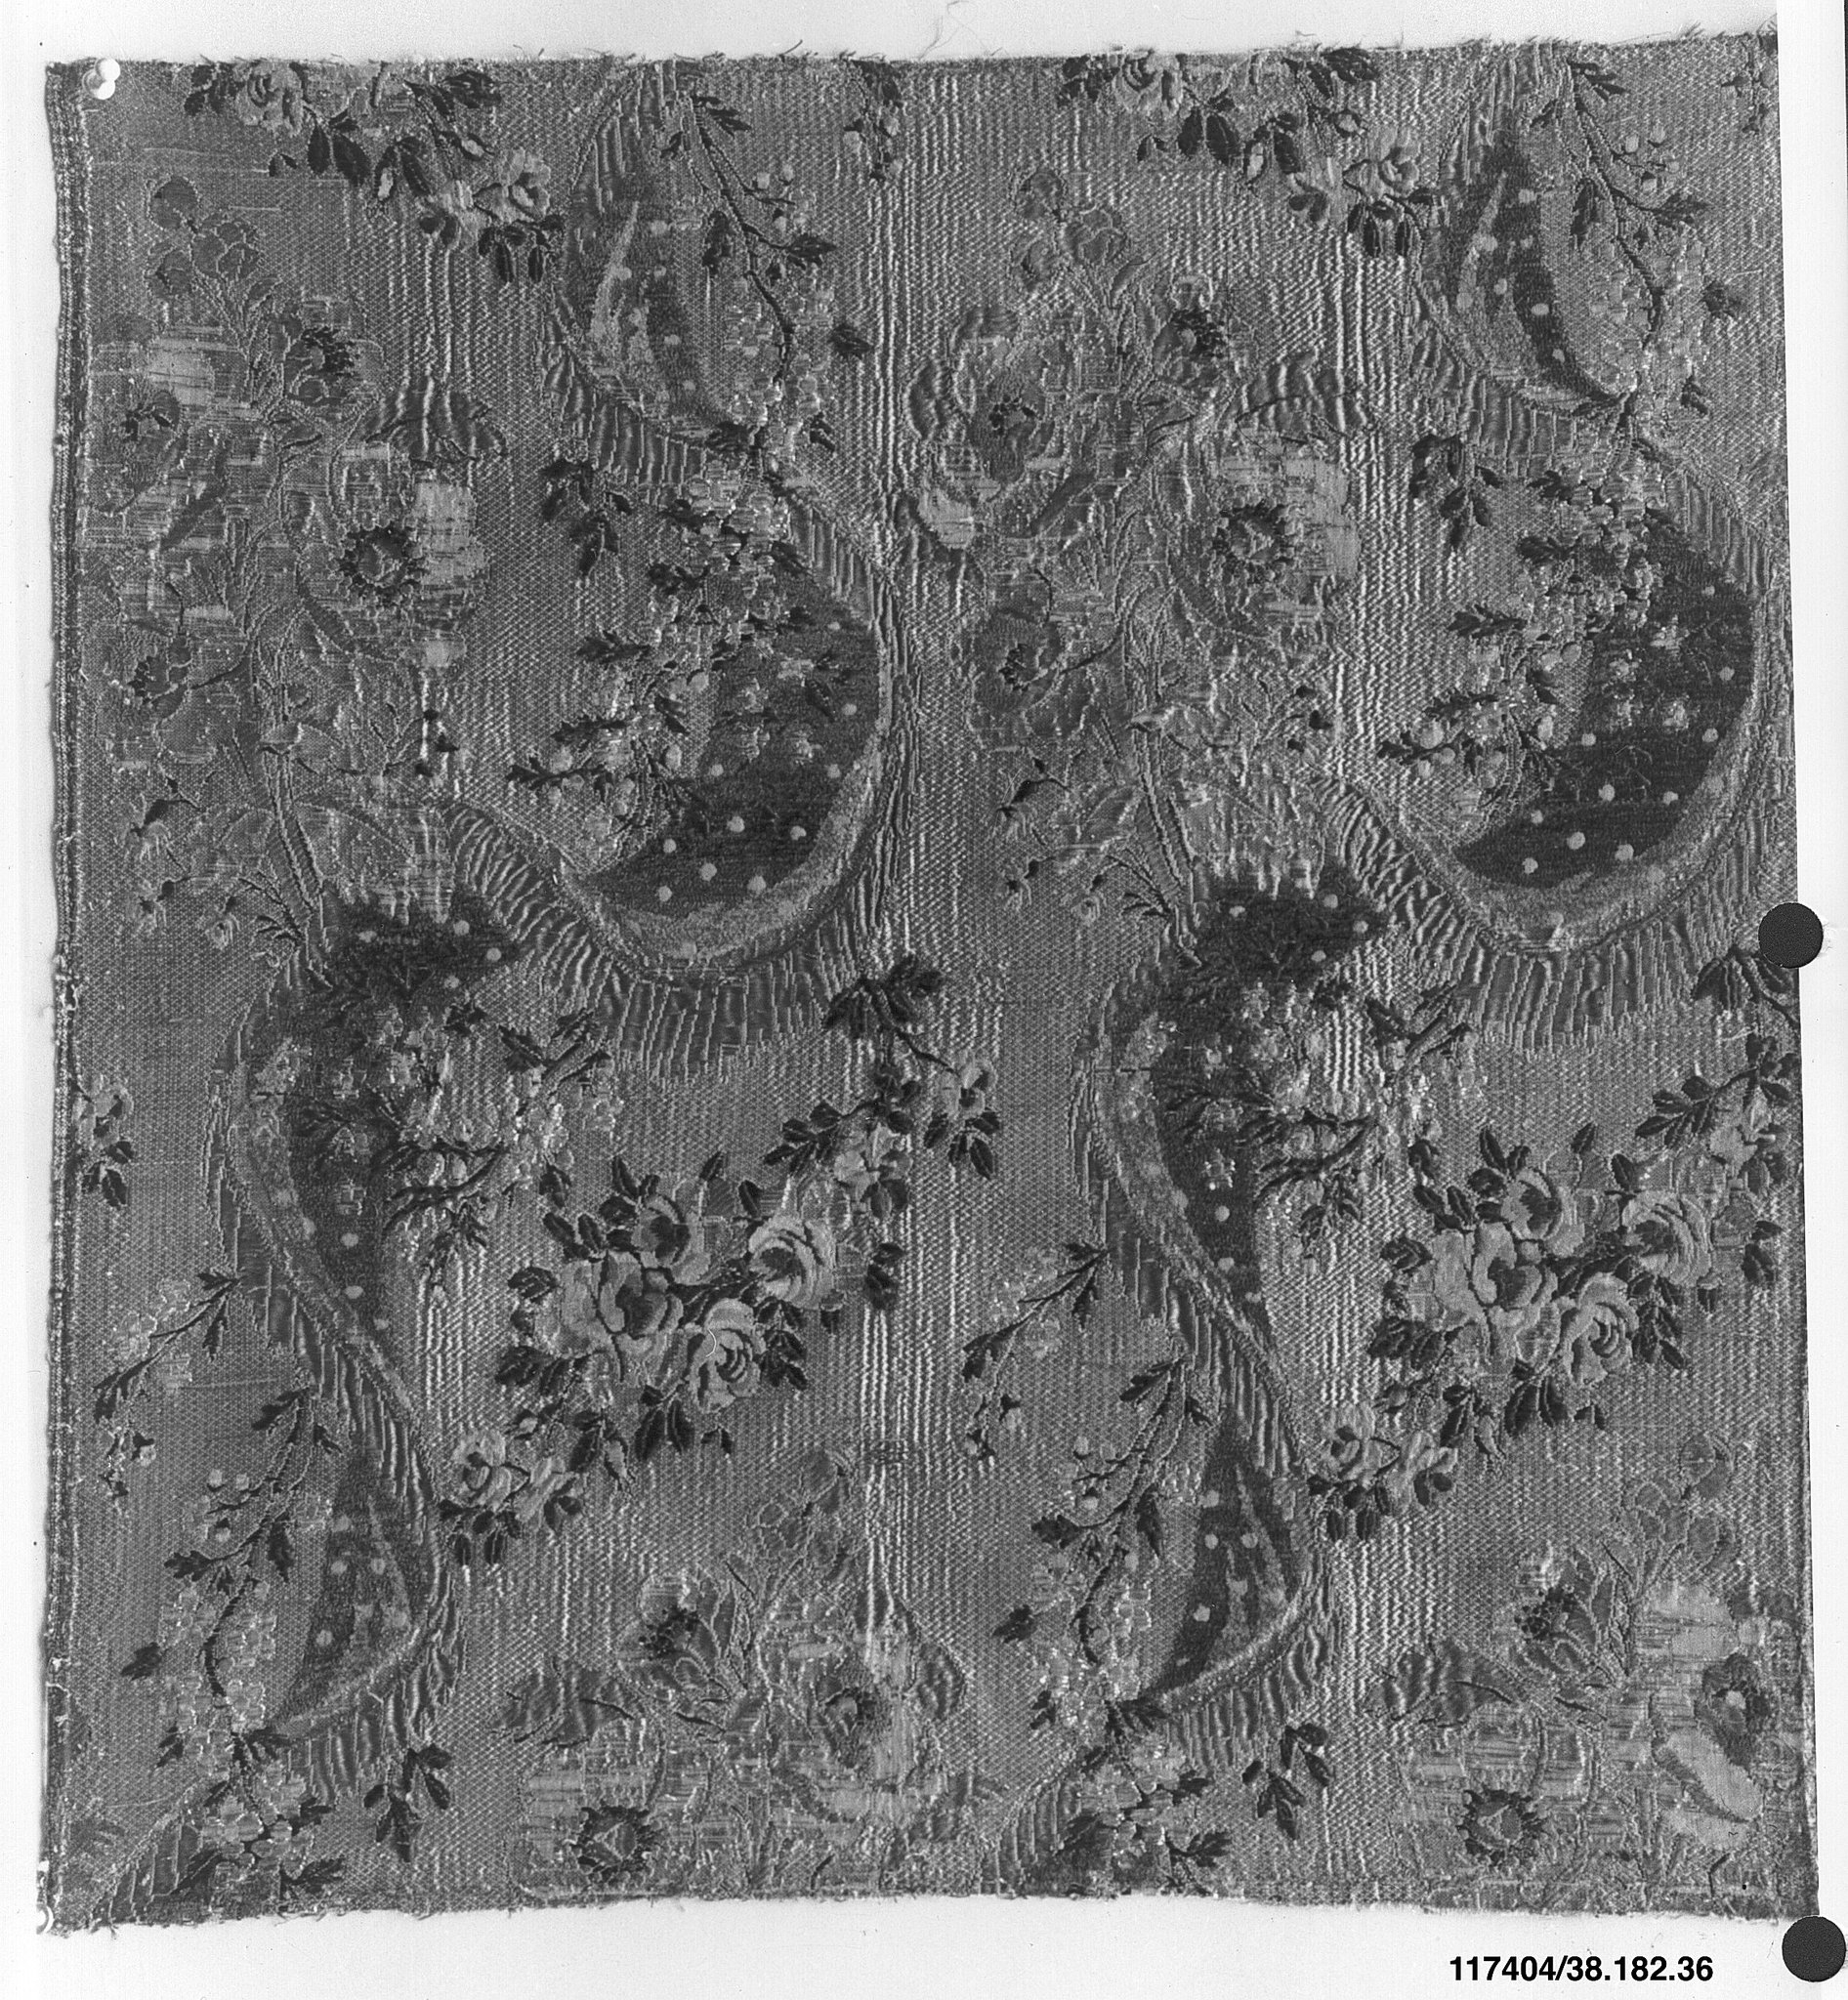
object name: piece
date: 1767-1800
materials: metal thread, silk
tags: flowers,leaves